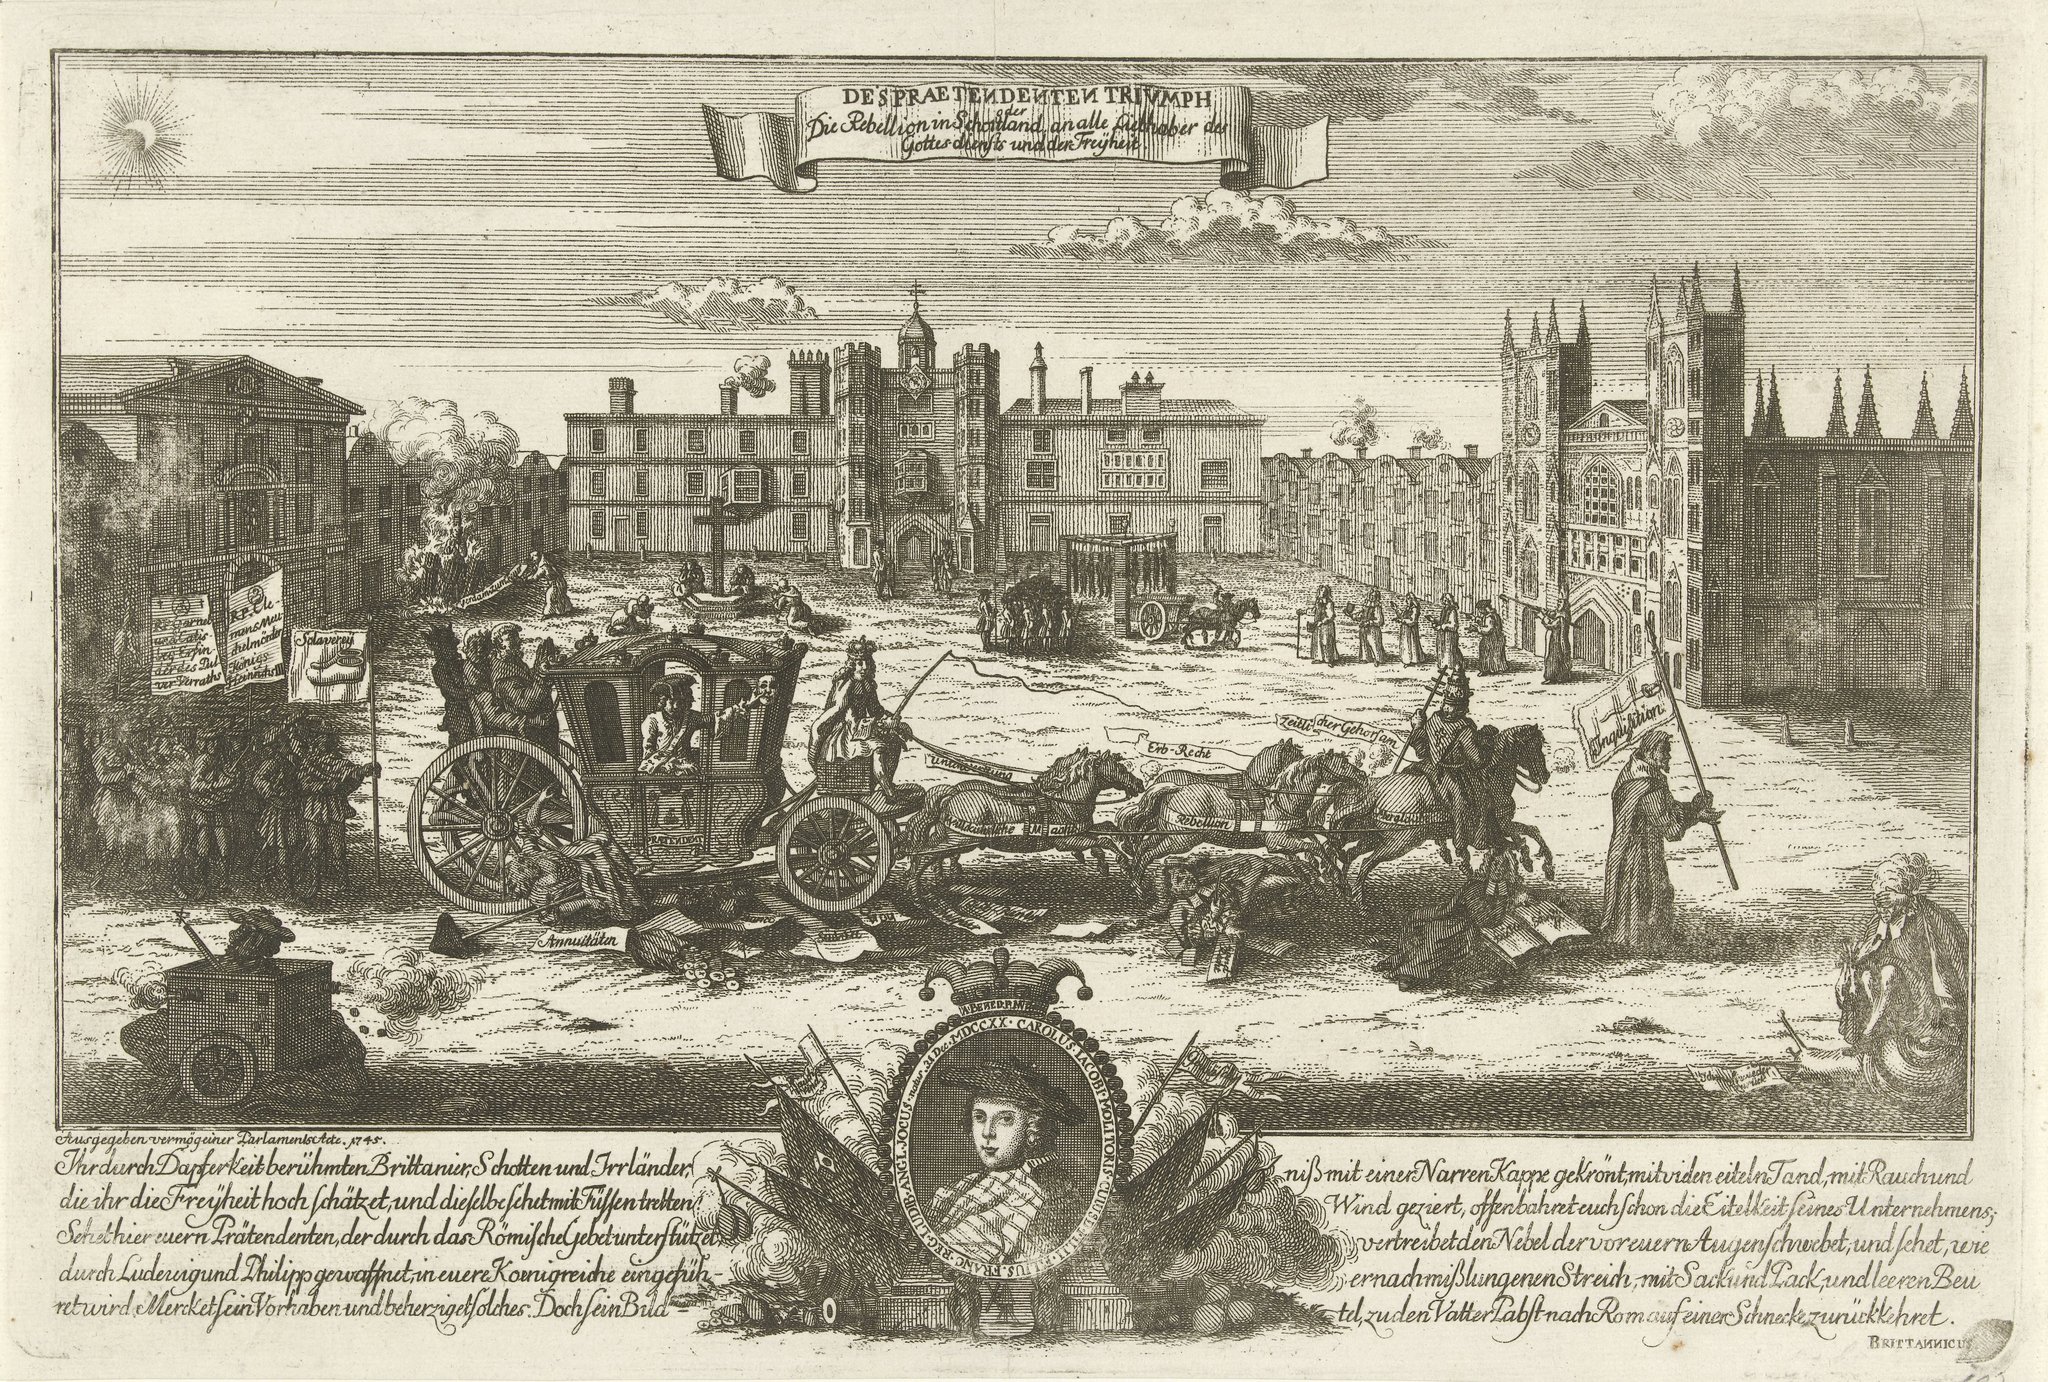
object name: cartoon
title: Despraetendenten Trivmph / Die Rebellion in Schottland an alle Liefhaber des Gottesdienst un der Freyheit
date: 1745-1746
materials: paper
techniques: etching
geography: germany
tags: louis xv of france, regular clerics, e.g. jesuits, redemptorists, solar eclipse, political caricatures and satires, westminster abbey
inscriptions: collector's mark: Lugt 2228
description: Spotprent op de Tweede Jacobitische Opstand in 1745. Plein met het gebouw van de Admiraliteit, St James's Palace en Westminster Abbey waarvoor de koets van de jonge prentendent Karel Eduard Stuart getrokken door hollende paarden, gemend door de Franse koning Lodewijk XV en voorafgegaan door de paus en een jezuïet met een vaandel van de Inquisitie. De koets gevolgd door een leger Schotten. Op de achtergrond scènes van de katholieke vervolging van protestanten. In de lucht een gedeeltelijke zonsverduistering. Onderaan een medaillon met het portret van Karel Eduard Stuart met narrenkap met aan weerszijden twee vijfreglige verzen in het Duits.